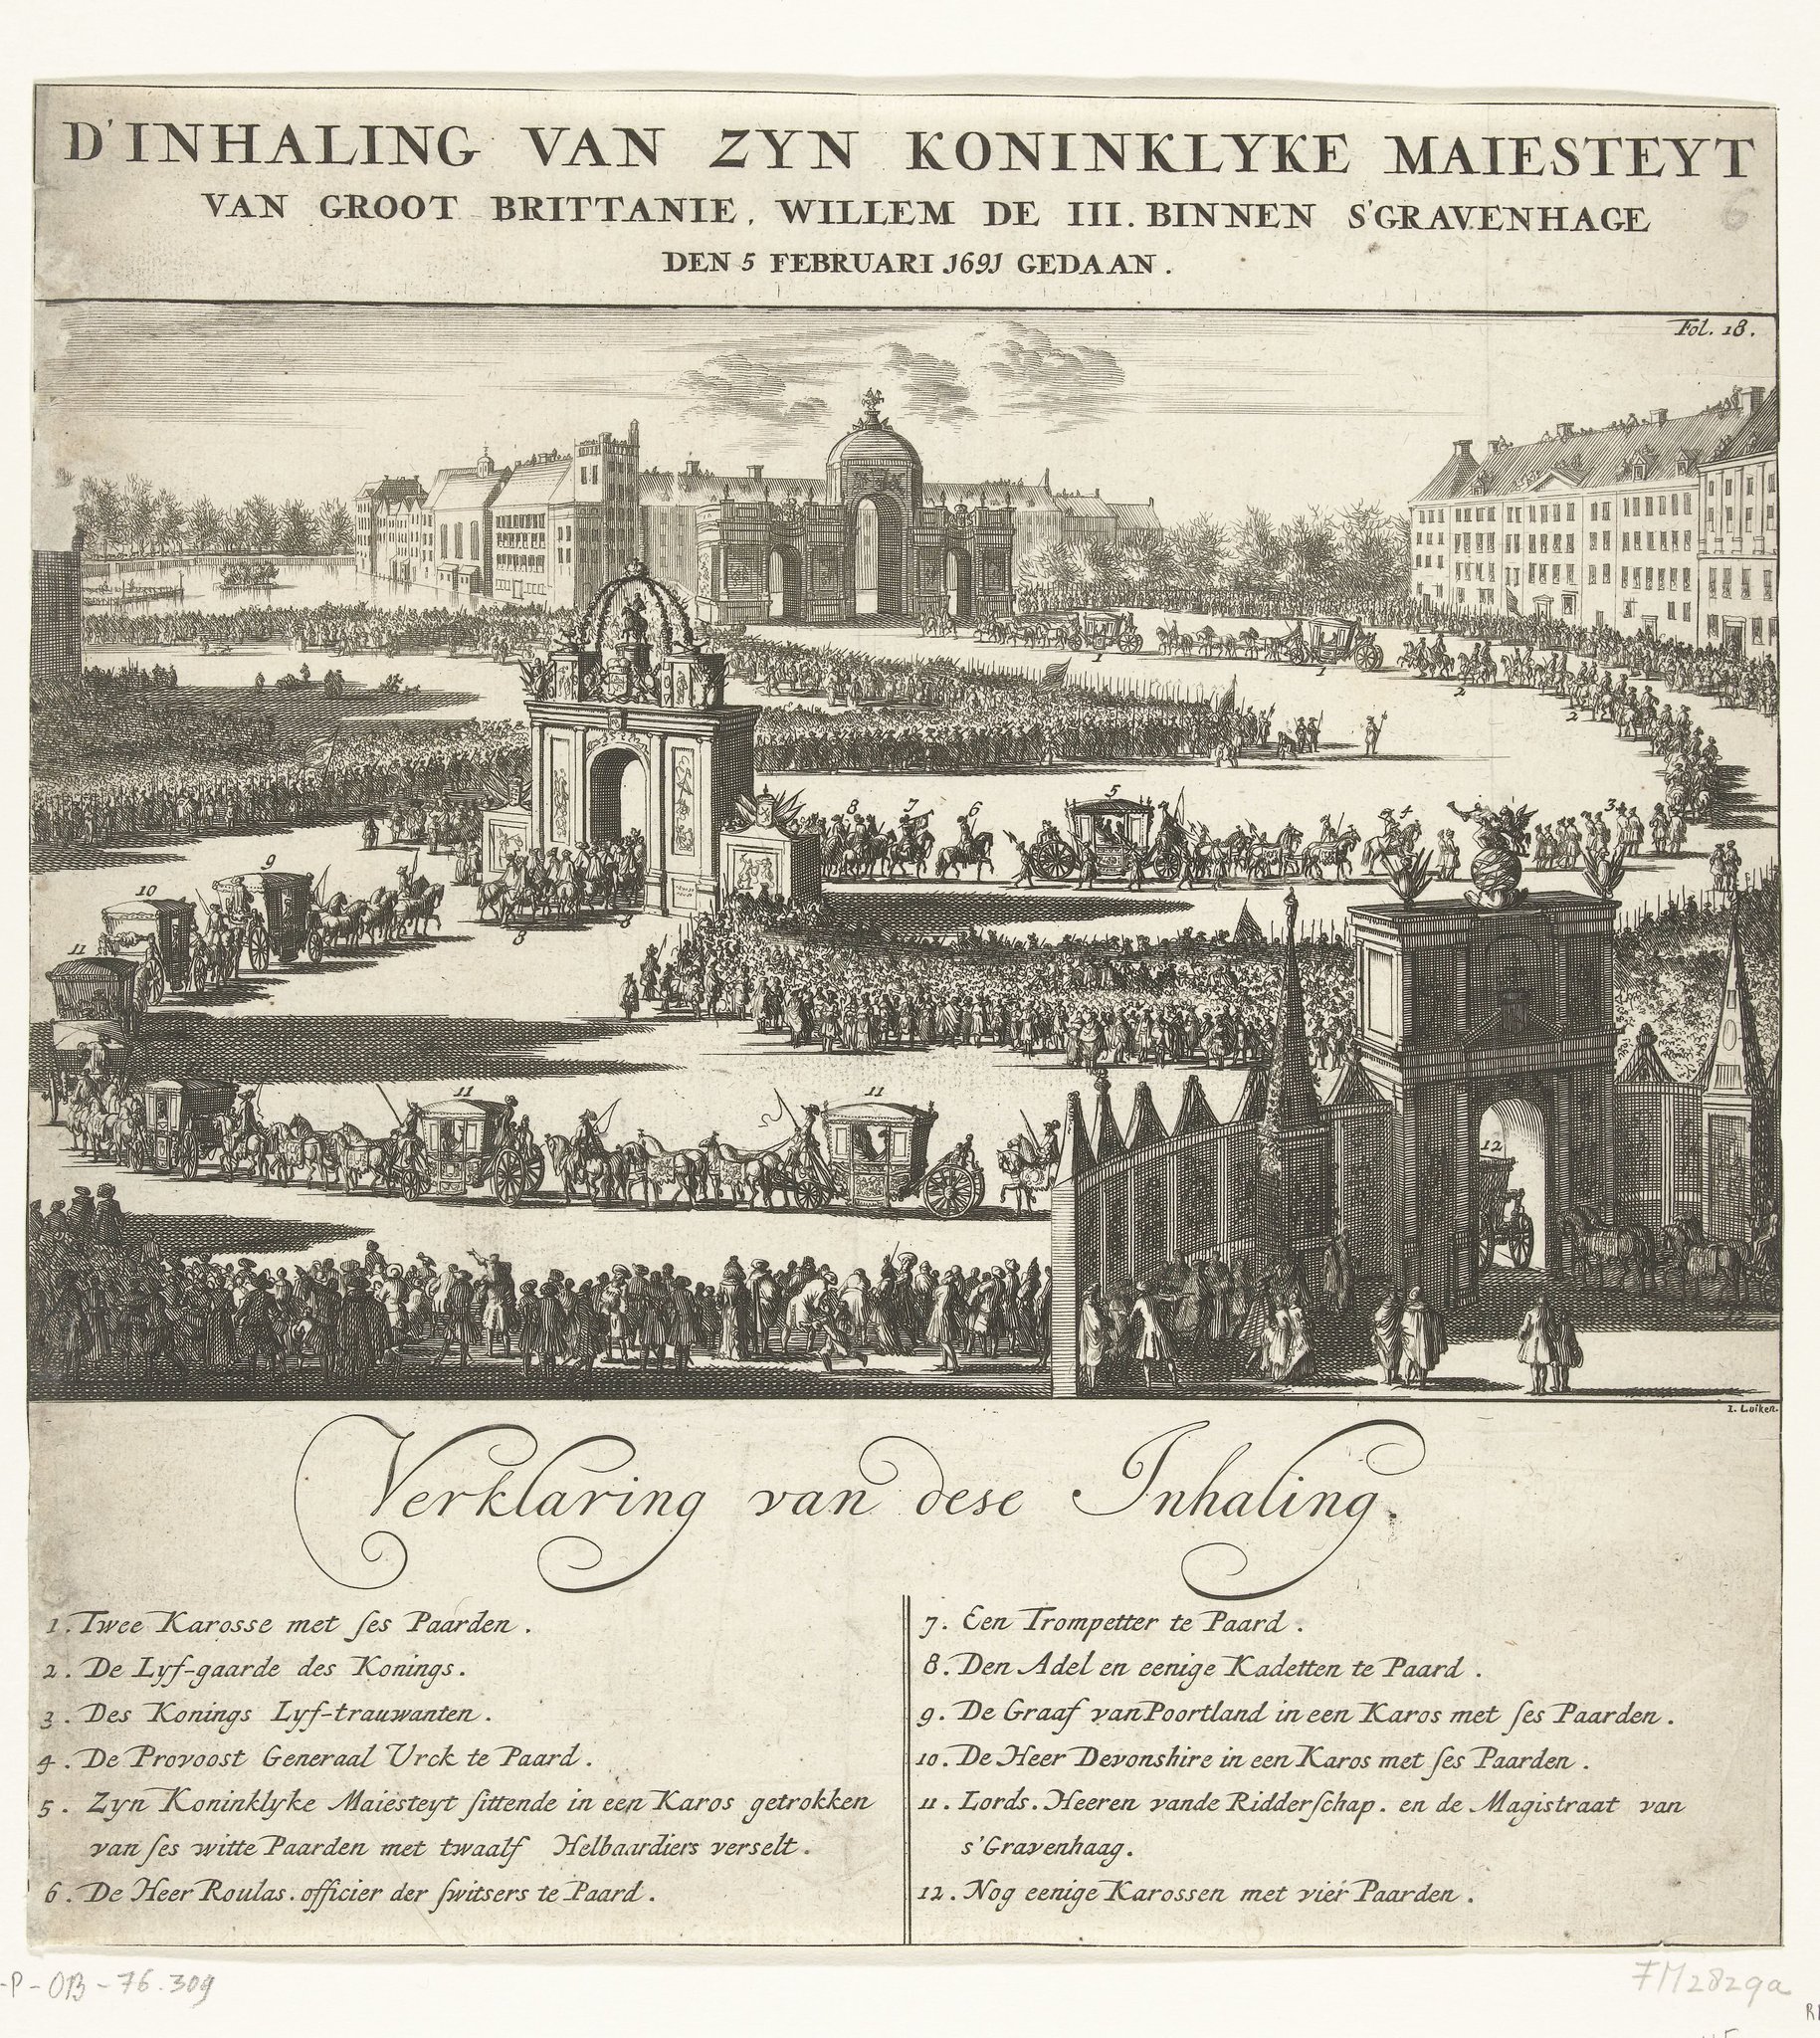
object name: print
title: Intocht van koning Willem III te Den Haag, 1691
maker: jan luyken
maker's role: draughtsman, print maker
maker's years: 1649-1712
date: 1691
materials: paper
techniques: etching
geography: northern netherlands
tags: william iii (prince of orange and king of england, scotland, and ireland), triumphal arch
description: De intrede van de stoet met koning Willem III door de triomfbogen opgesteld bij het Buitenhof naar het Stadhouderlijk Kwartier, 5 februari 1691. Onder de plaat de legenda 1-12. Gemerkt rechtsboven: Fol. 18.